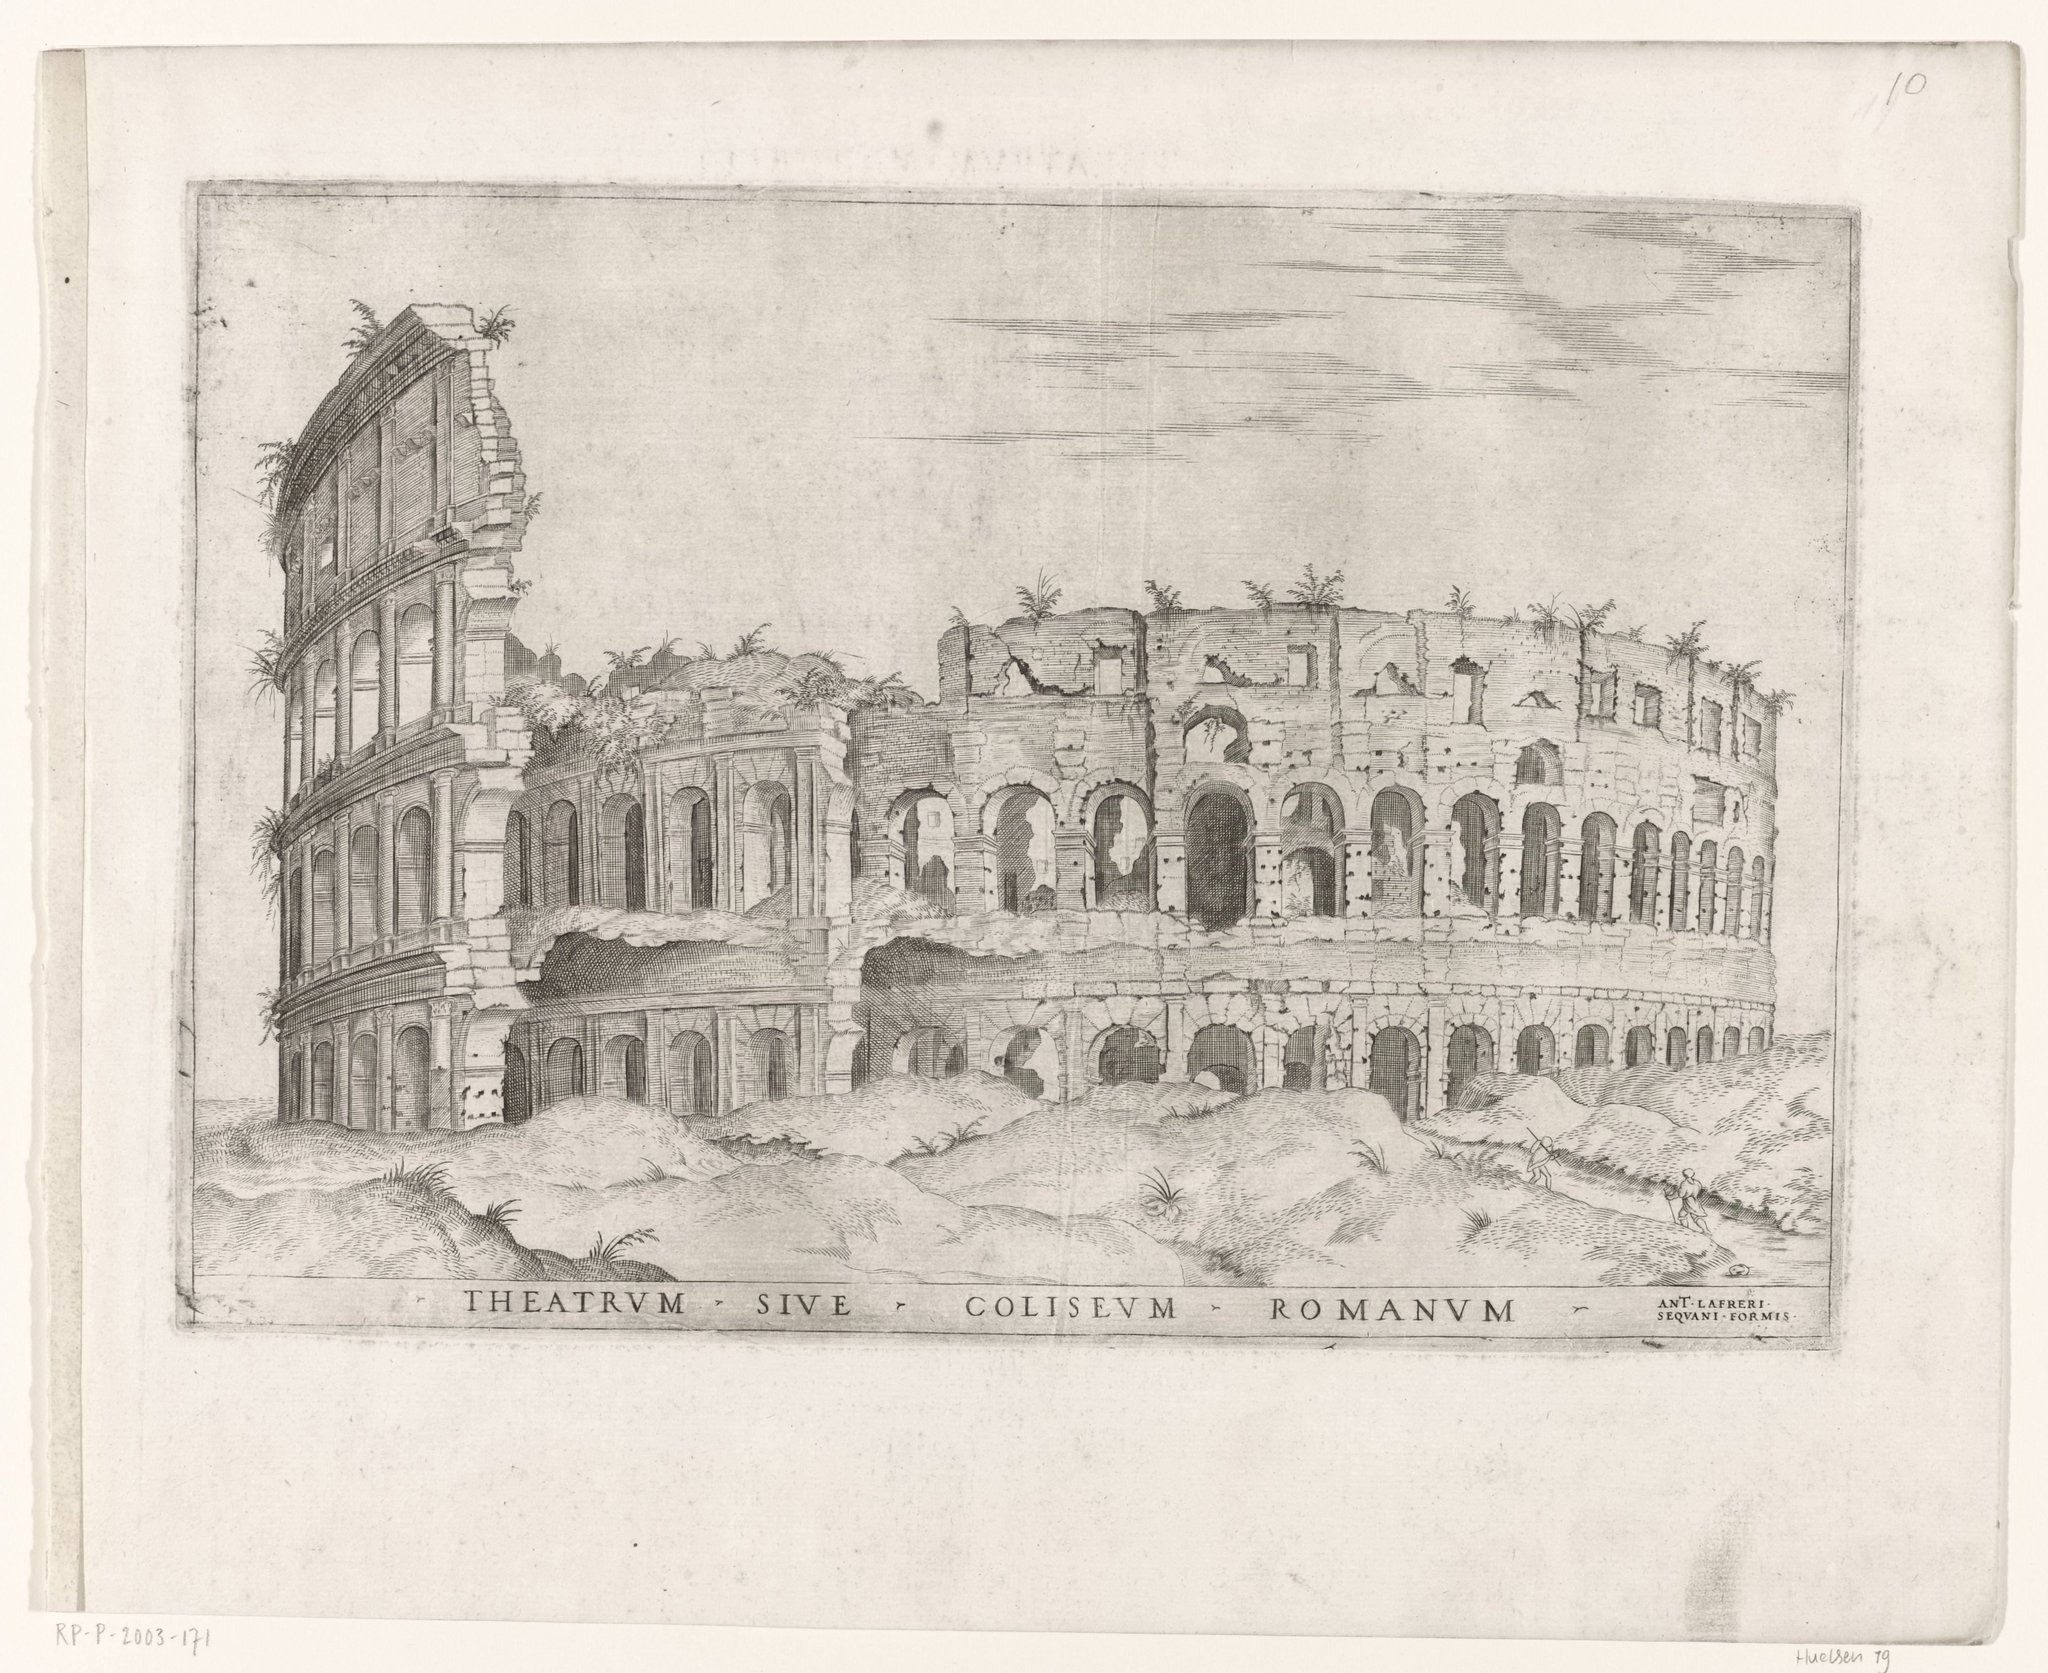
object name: print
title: Theatrum sive Coliseum Romanum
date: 1522-1577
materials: paper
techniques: engraving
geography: italy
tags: grounds, fields and accomodations for sports, games and physical performances (+ out of doors (sports, games, etc.)), rome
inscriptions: collector's mark: Lugt 2228, collector's mark: Lugt 2760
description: Deze prent behoort tot het prentcorpus dat bekend staat als de ‘Speculum Romanae Magnificentiae’ (‘Spiegel van Romeinse pracht’). Dit corpus, bestaande uit prenten met voorstellingen van kunstwerken en gebouwen uit het antieke en het moderne Rome, vond zijn oorsprong bij uitgevers Antonio Salamanca en Antonio Lafreri. Deze twee buitenlandse uitgevers bundelden hun krachten te Rome in de periode 1553-1563. Hun prenten werden al snel razend populair bij toeristen en verzamelaars, die de prenten individueel of in grote groepen aanschaften. Grote groepen Speculum-prenten werden vaak op aanvraag samengebonden in albums. Er zijn verschillende Speculum-albums overgeleverd die allemaal verschillen van inhoud. Tussen 1573 en 1577 gaf Antonio Lafreri een speciale titelpagina uit (met de titel ‘Speculum Romanae Magnificentiae’) die mensen voor hun verzamelingen konden voegen. Het overlijden van Lafreri in 1577 betekende niet het einde van het corpus. Een groot deel van de koperplaten ging over op Claudio en Stefano Duchetti. De rest raakte verspreid over verschillende andere uitgevers. De populariteit van de Speculum-prenten wist nog geruime periode uitgevers te inspireren tot het laten maken van kopieën en het toevoegen van nieuwe prenten aan het corpus.